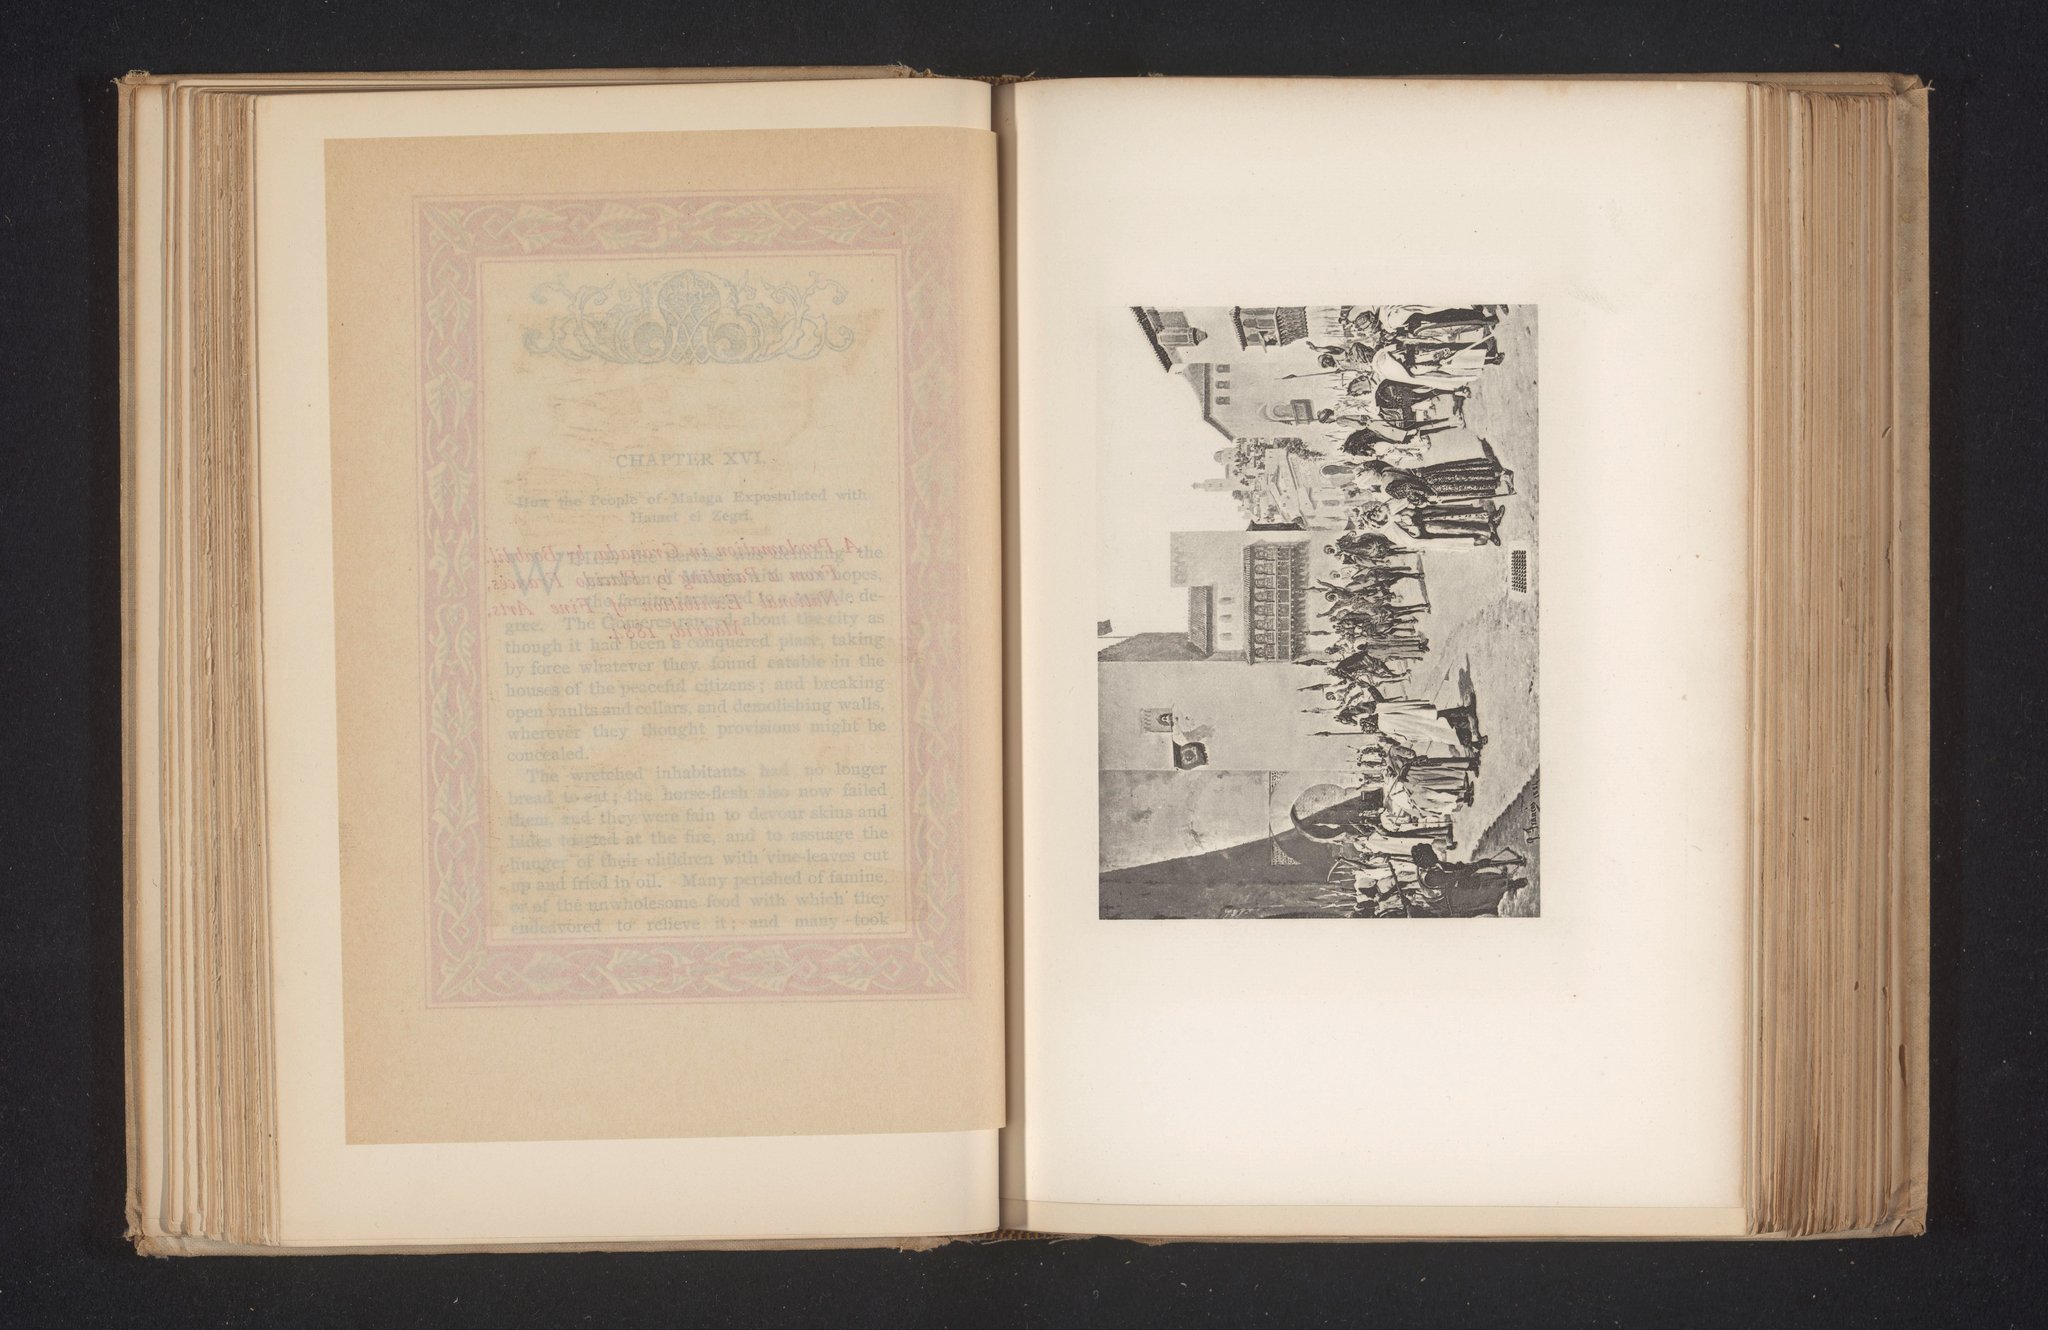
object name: page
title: A Proclamation in Granada, by Boabdil. From a Painting by Placido Francés, National Exhibition of Fine Arts, Madrid, 1884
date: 1883-1893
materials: paper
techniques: photoaquatint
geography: madrid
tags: proclamation of a ruler